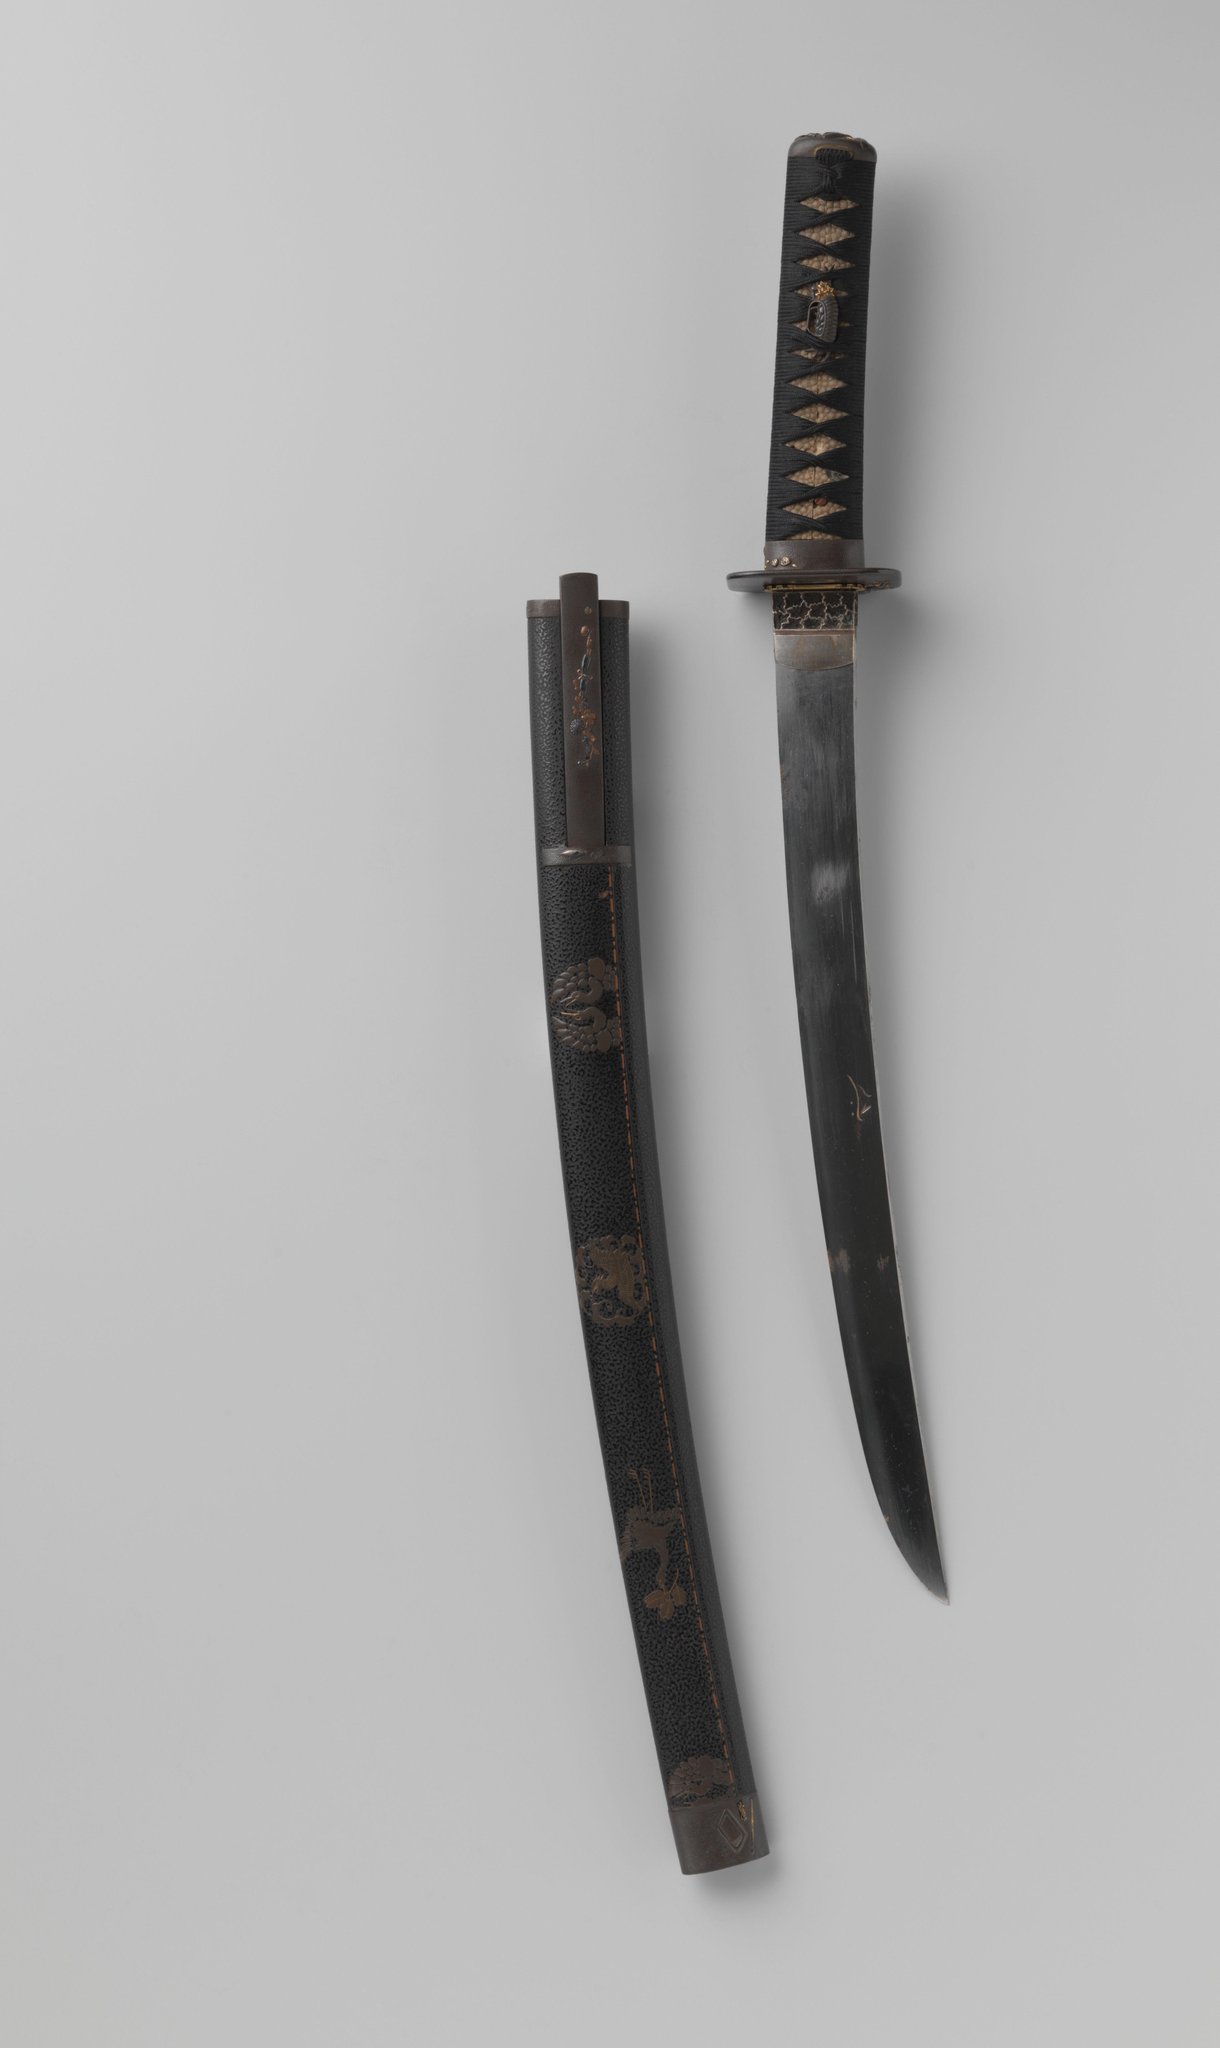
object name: armor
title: Een menuki in de vorm van twee poppen en een in de vorm van een mandje; rechthoekige tsuba met relief-versiering; kozuka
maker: yoshimitsu (kozuka)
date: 1600-1900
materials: metal, wood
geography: japan